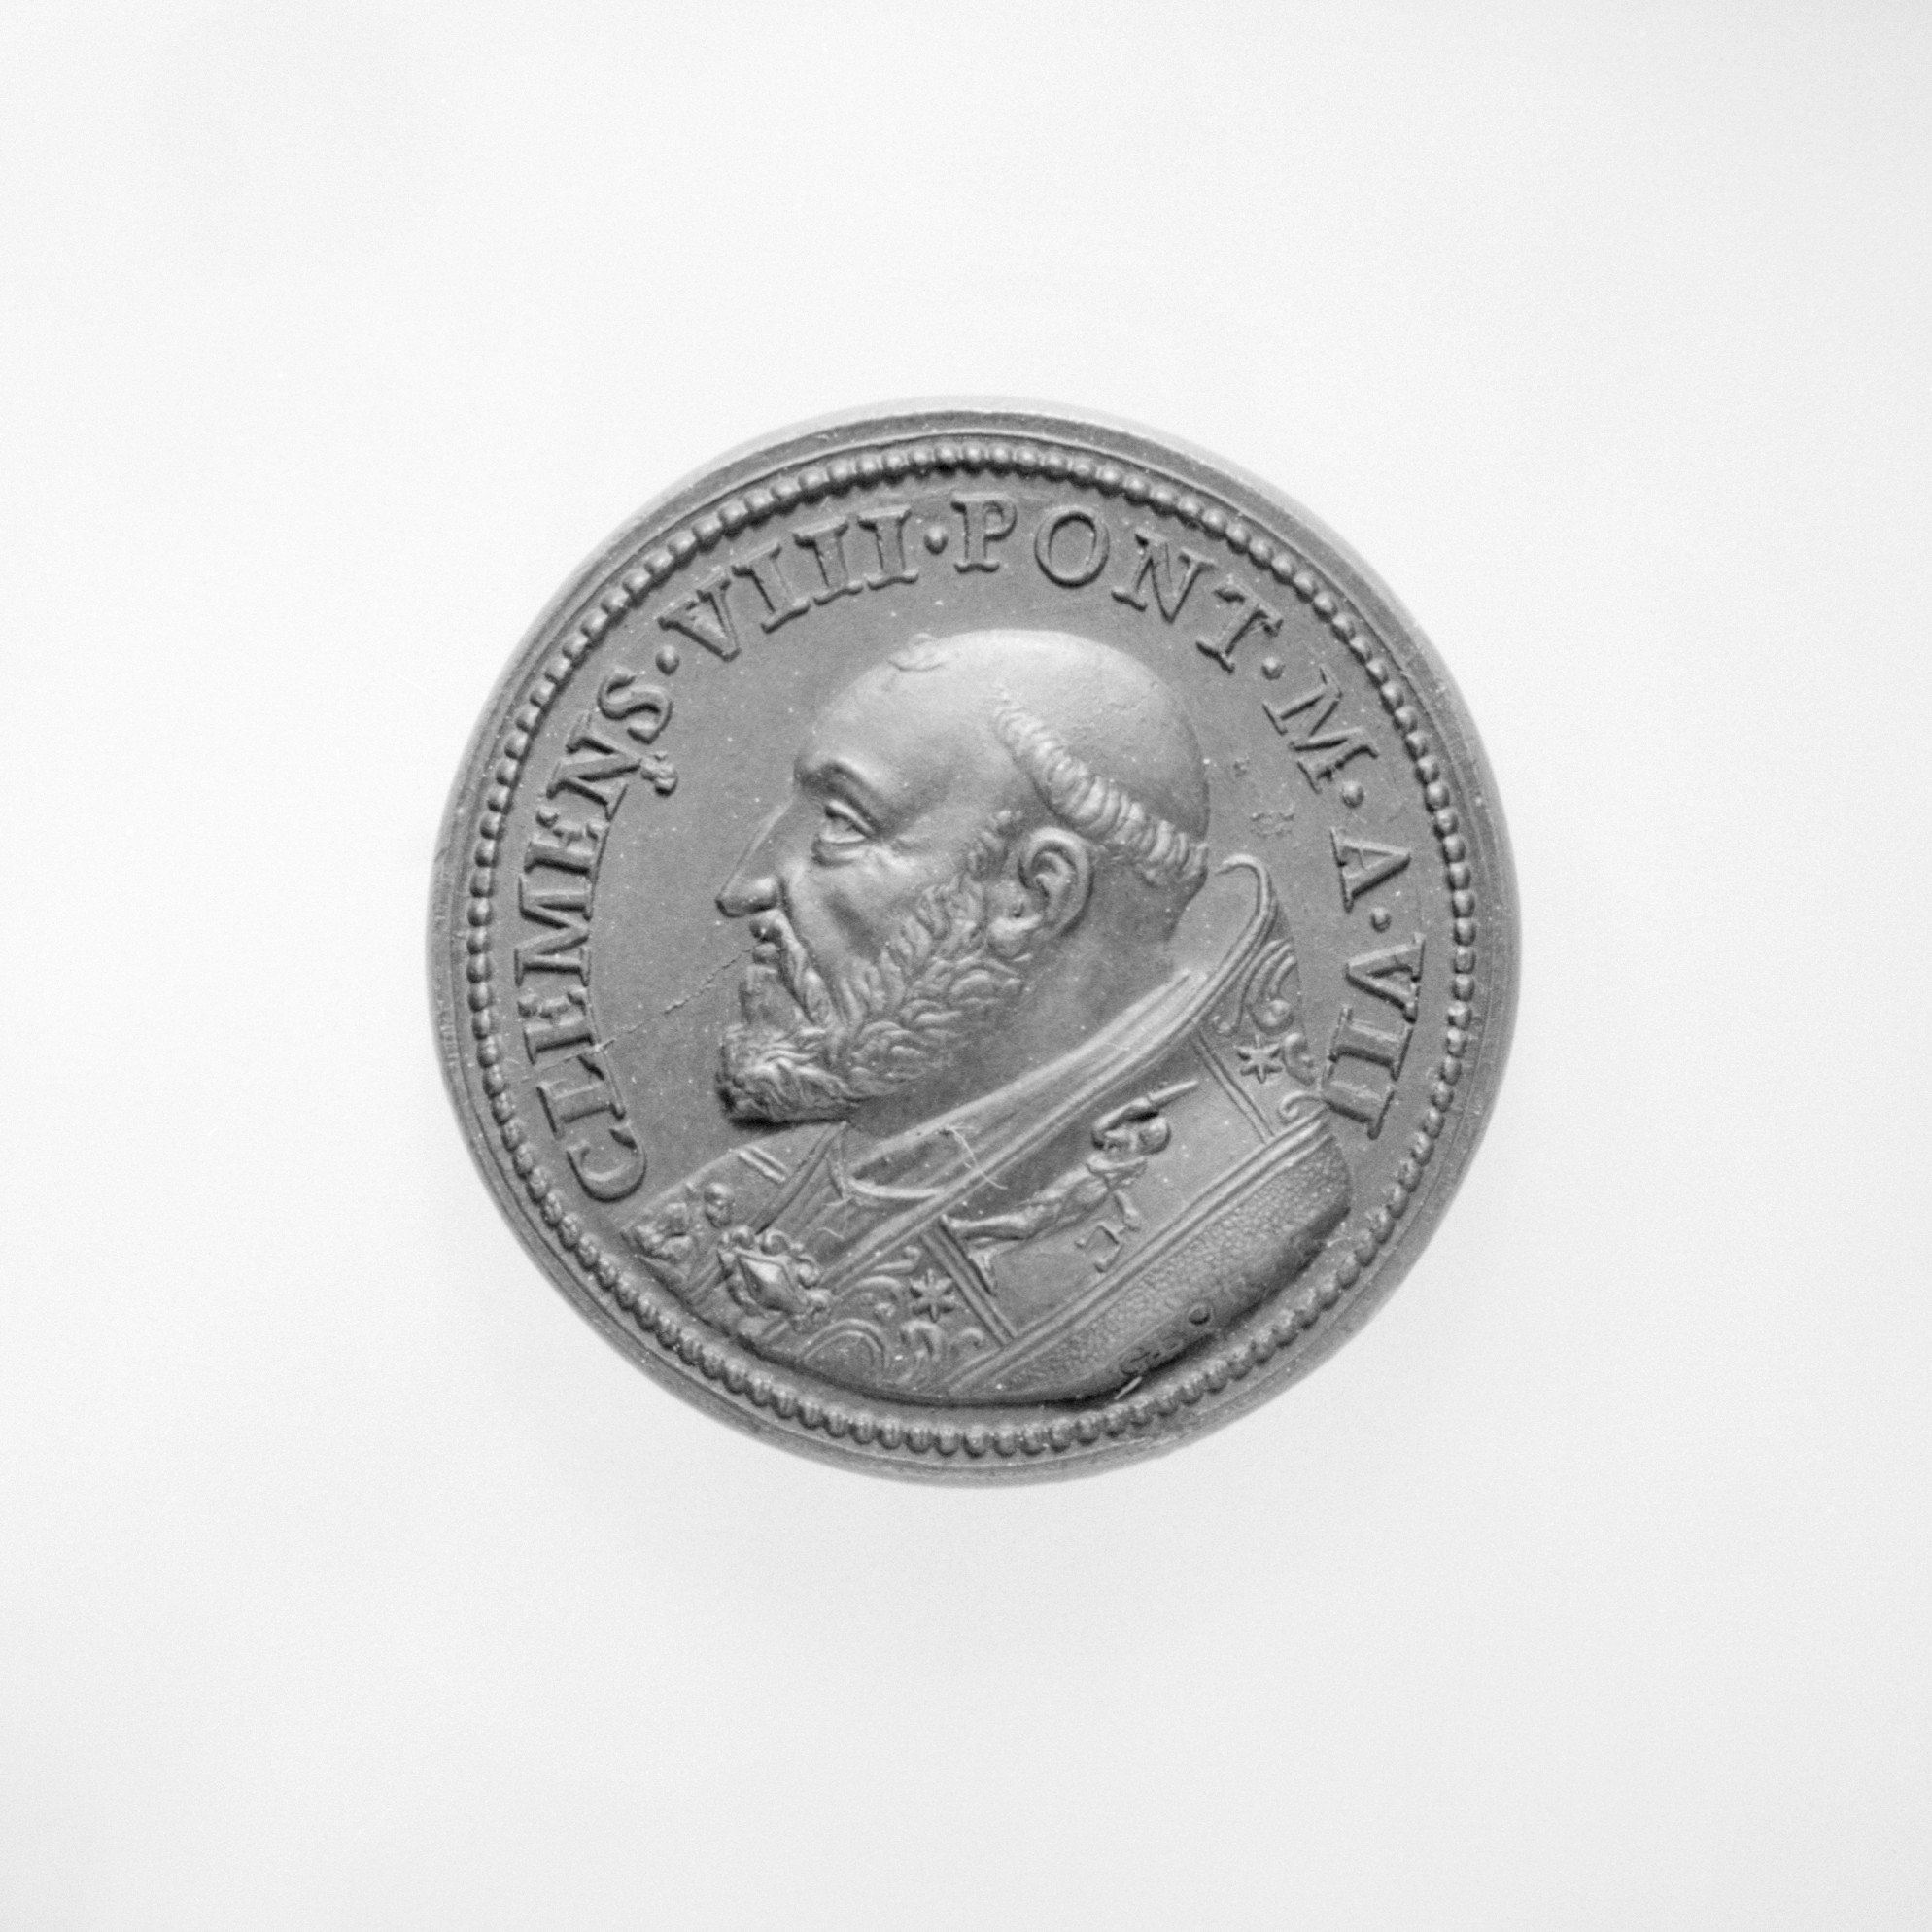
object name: medal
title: Clement VIII (Pope, 1592–1605)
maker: giorgio rancetti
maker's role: artist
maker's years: 1545-1611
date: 1598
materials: bronze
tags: men,profiles,popes